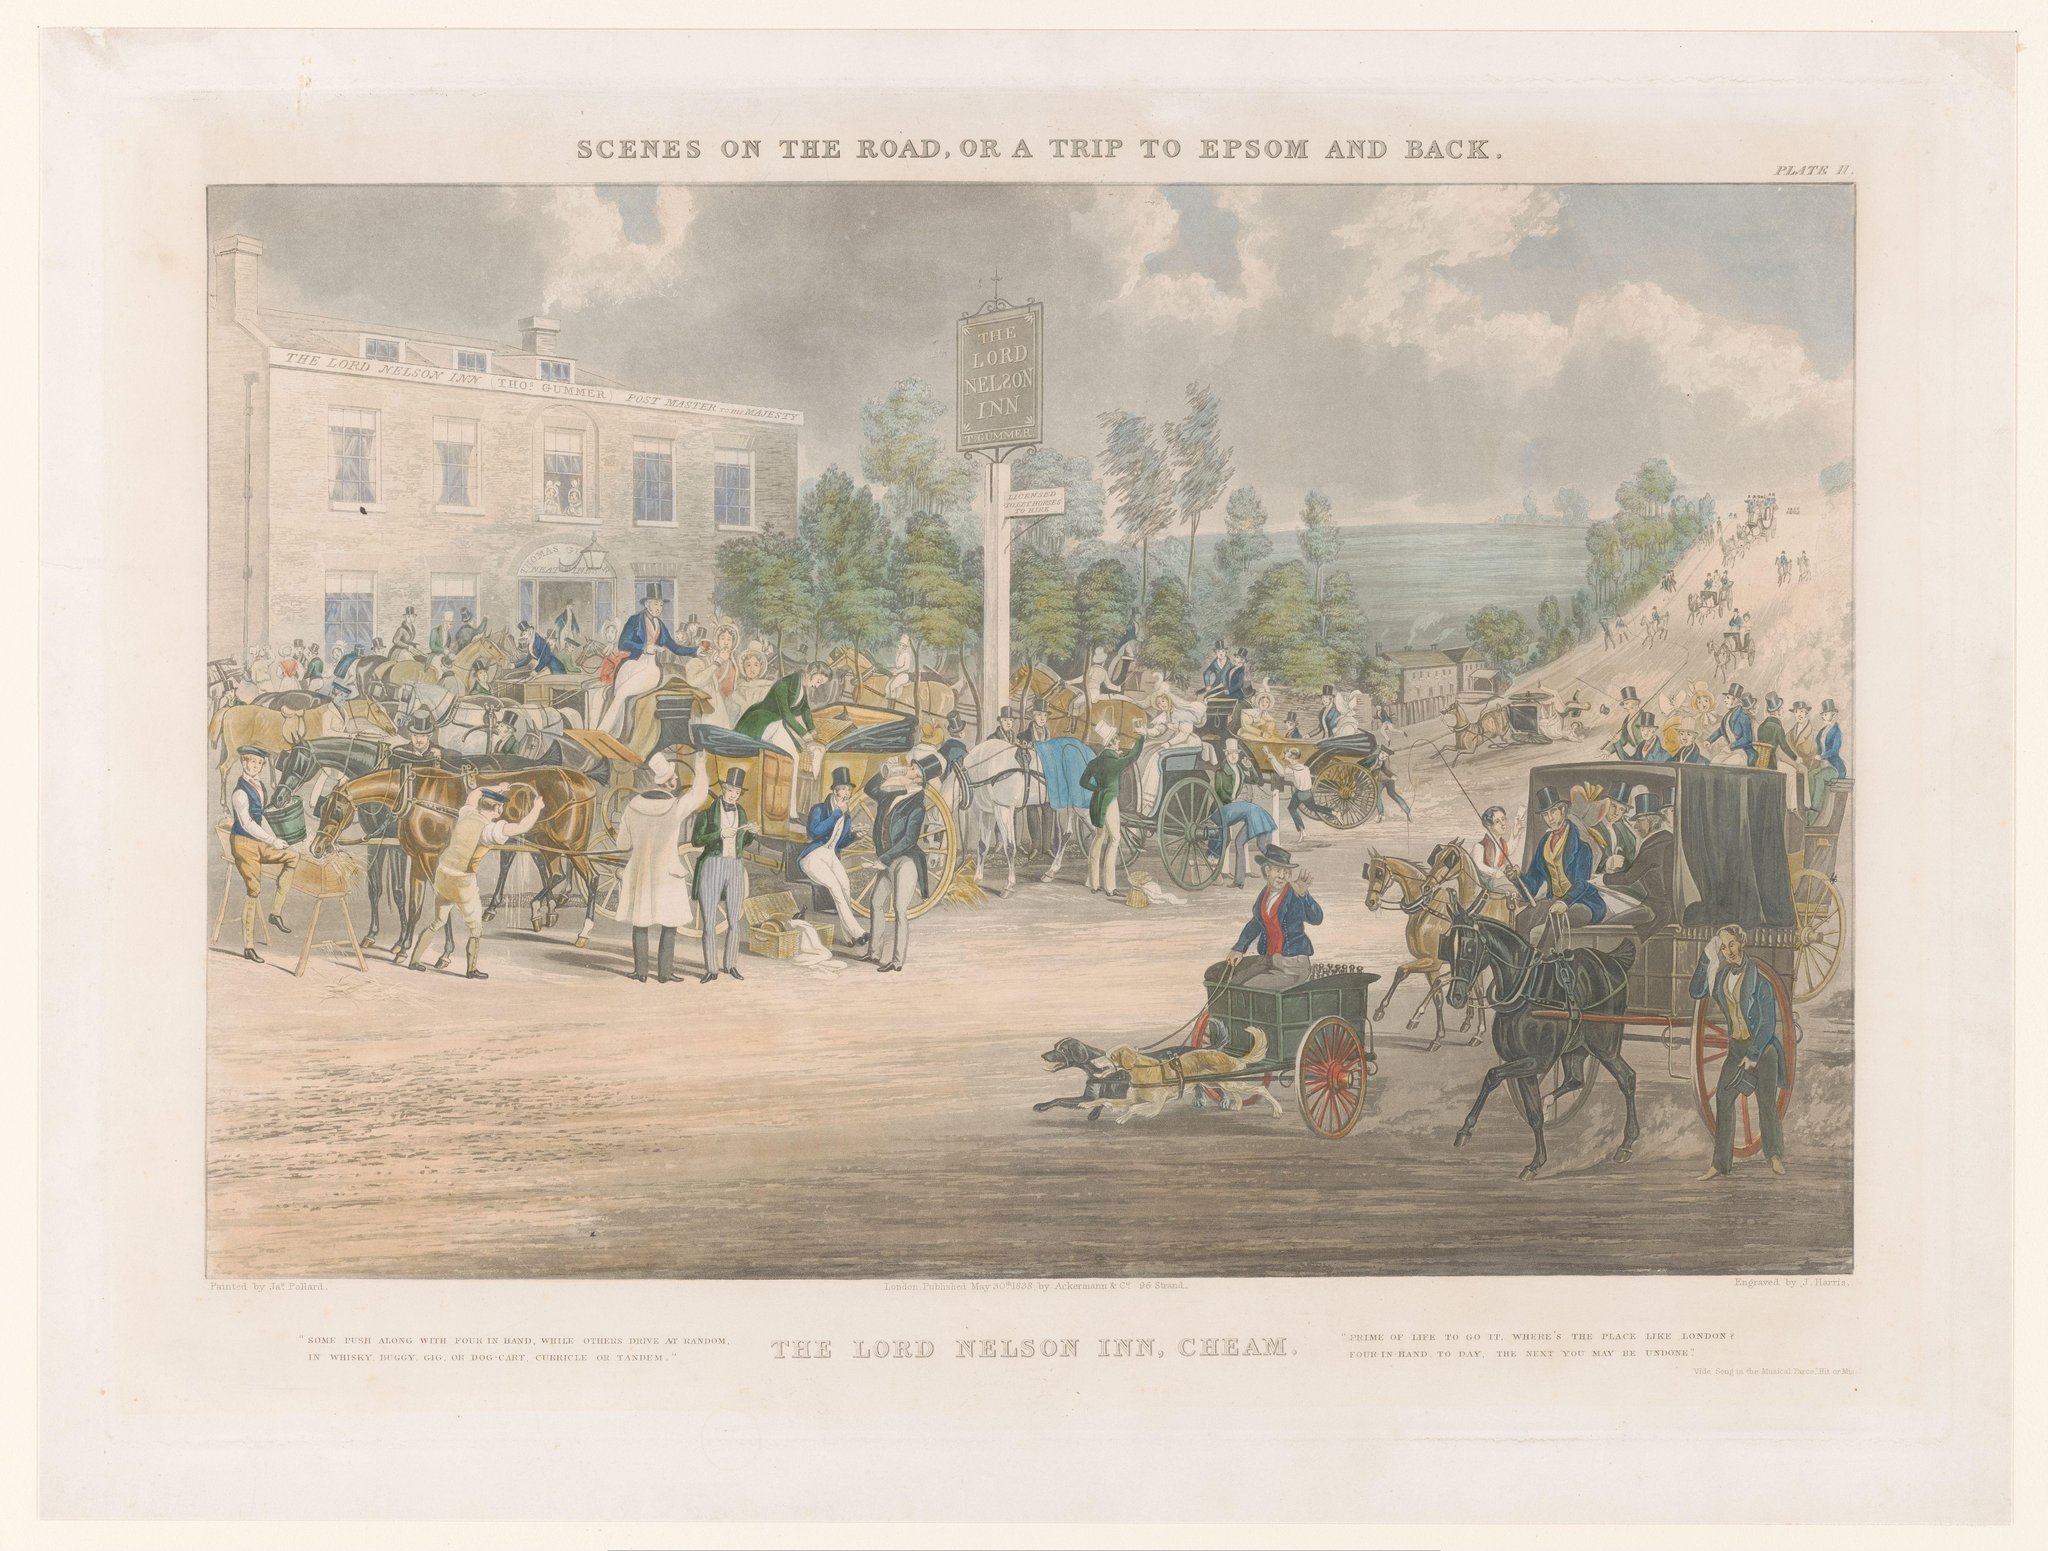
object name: print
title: Straatgezichten rondom Epsom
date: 1838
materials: paper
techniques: aquatint, etching, hand coloring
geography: london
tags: traffic on land, lending, letting, hotel, hostelry, inn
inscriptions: collector's mark: Lugt 2228